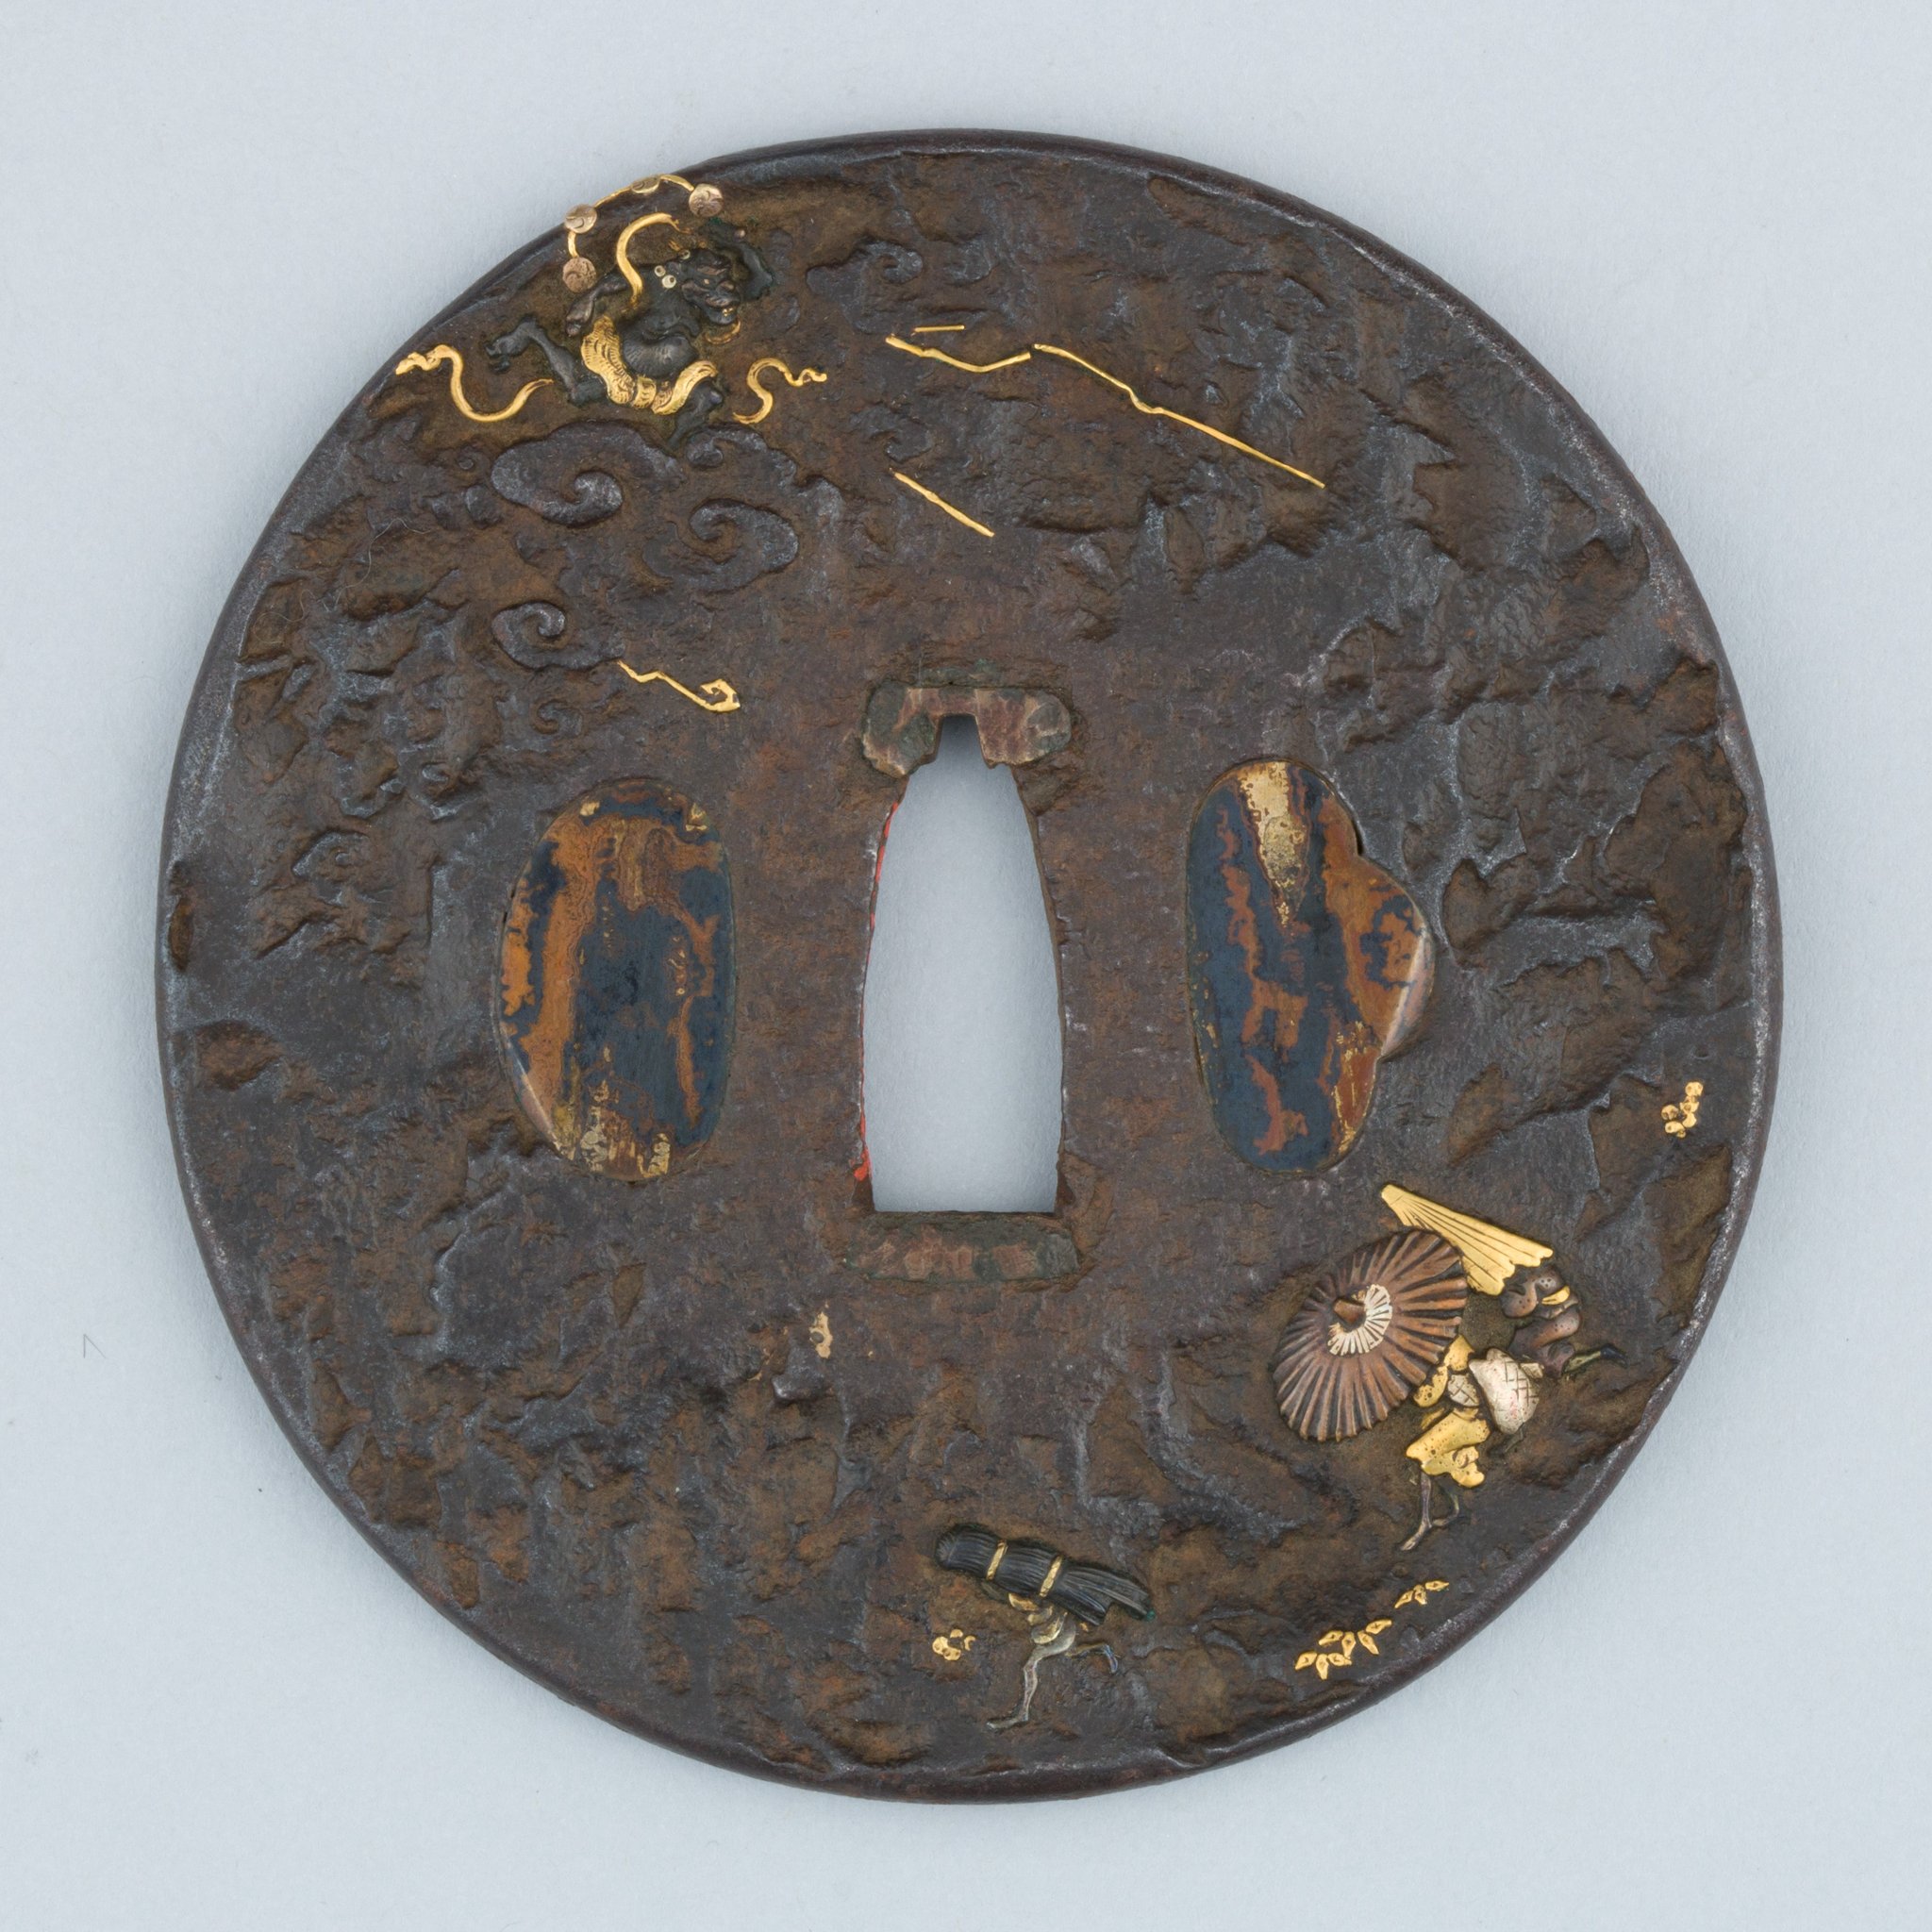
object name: sword guard tsuba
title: Sword Guard (Tsuba)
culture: japanese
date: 1767-1833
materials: copper, gold alloy, gold, iron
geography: japan